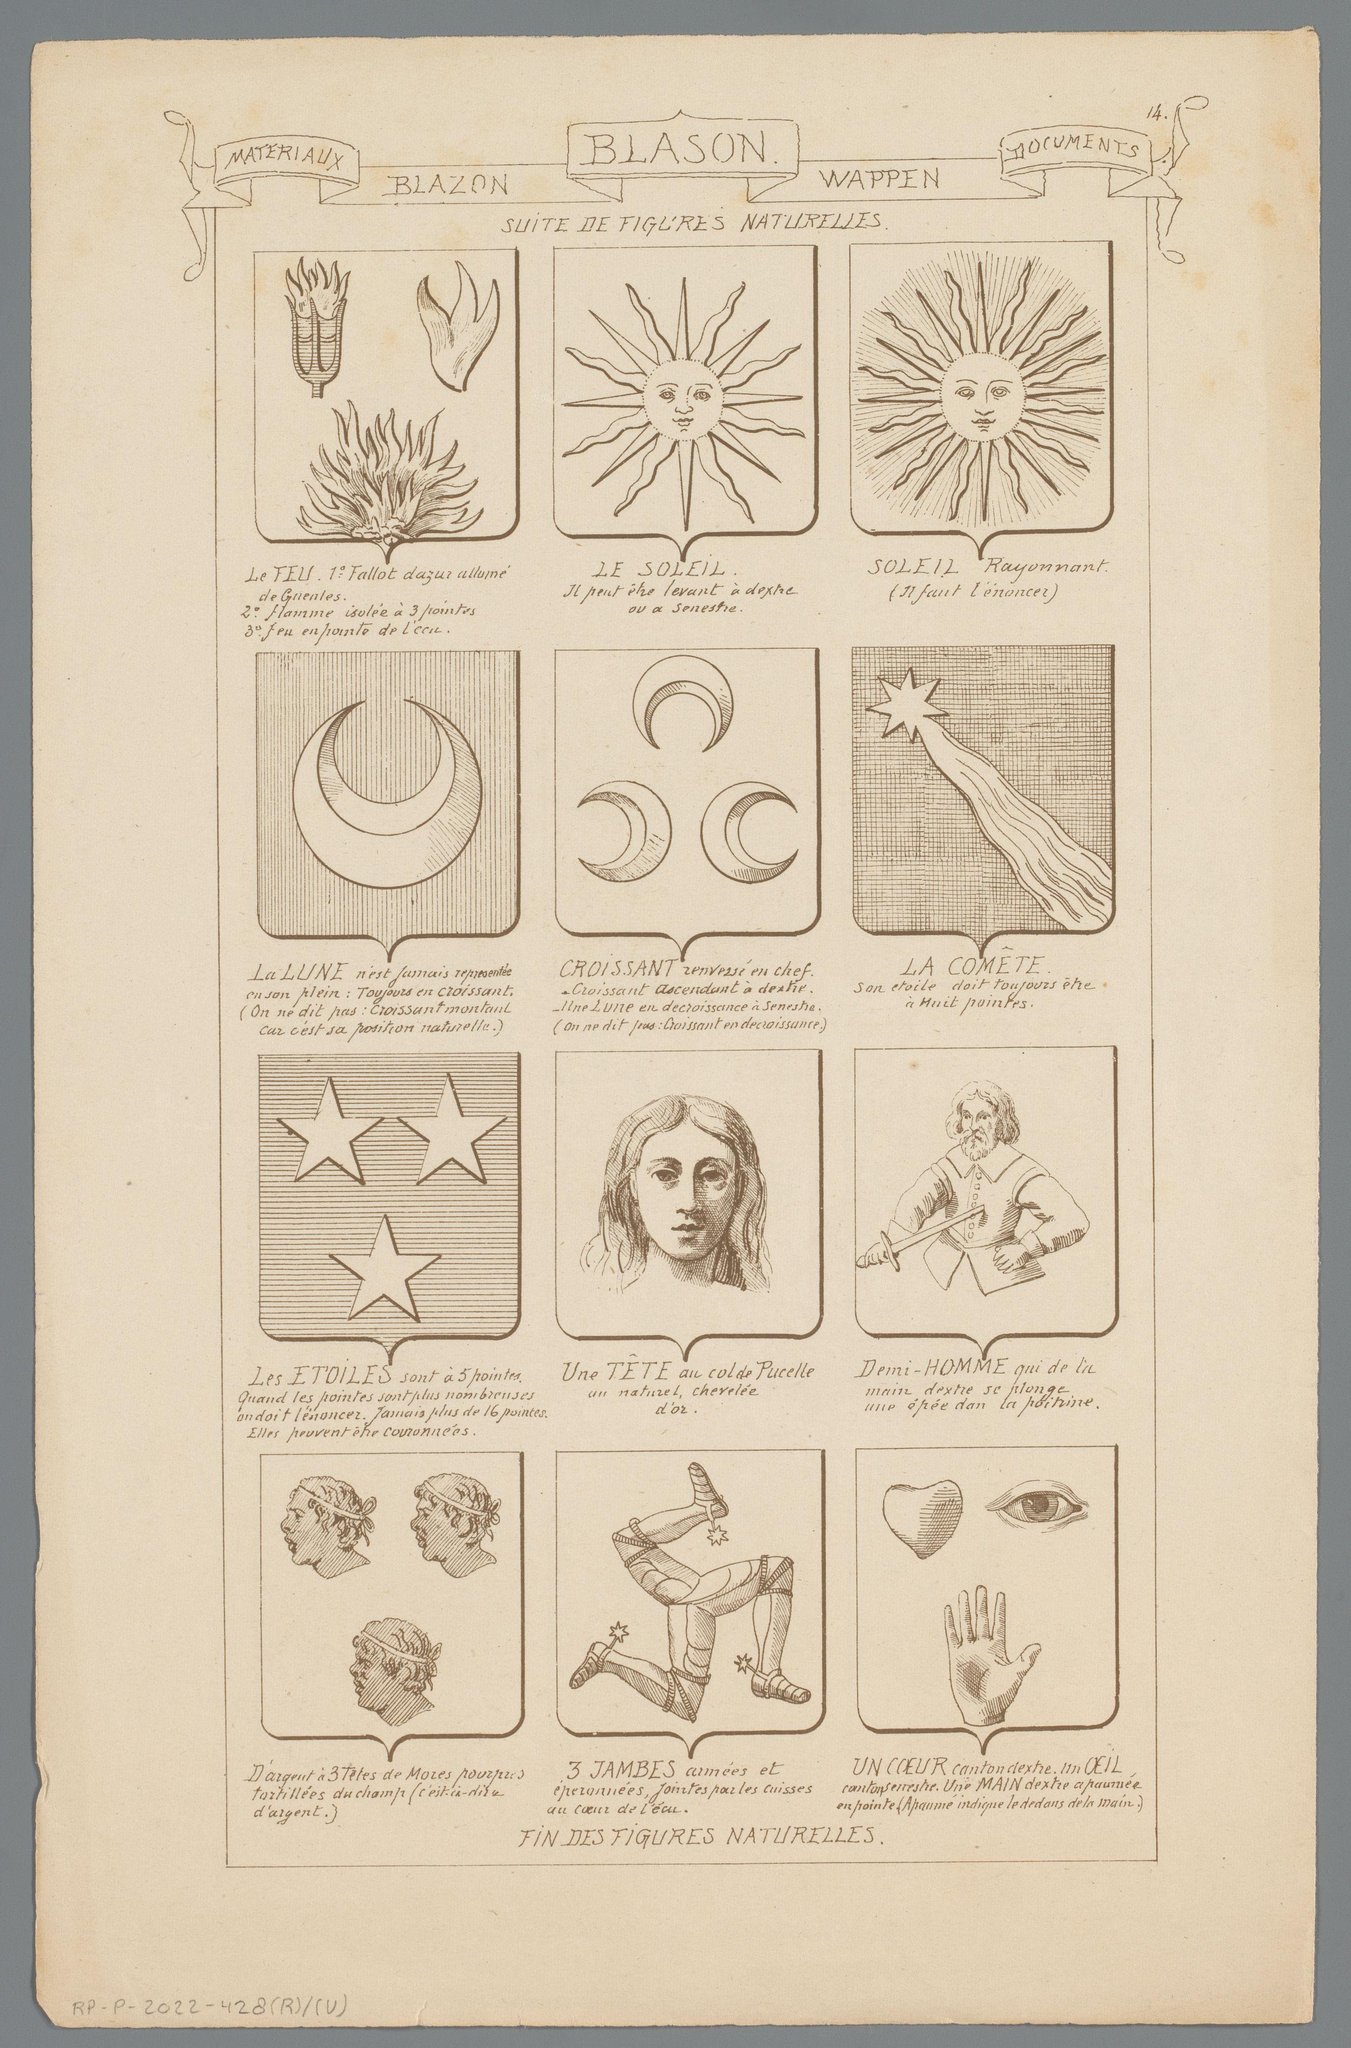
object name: print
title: Voorbeelden van wapenschilden met astronomische motieven en mensen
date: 1872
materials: paper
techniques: lithograph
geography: paris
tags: armorial bearing, heraldry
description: Prent uit: Raguenet, A. Matériaux & documents d'architecture classés par ordre alphabétique. Parijs: H. Cagnon, 1872.